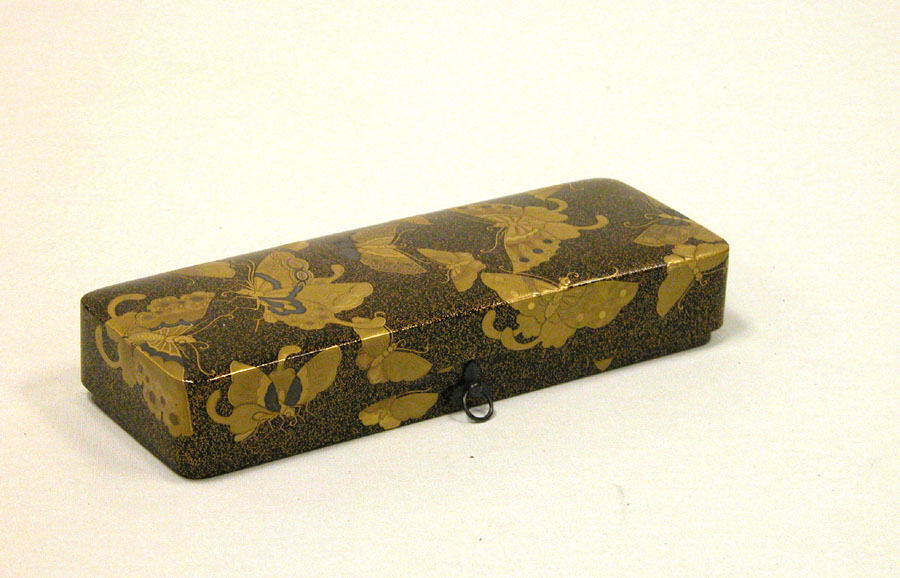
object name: letter box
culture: japanese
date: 1701-1800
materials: gold, lacquer, silver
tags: butterflies